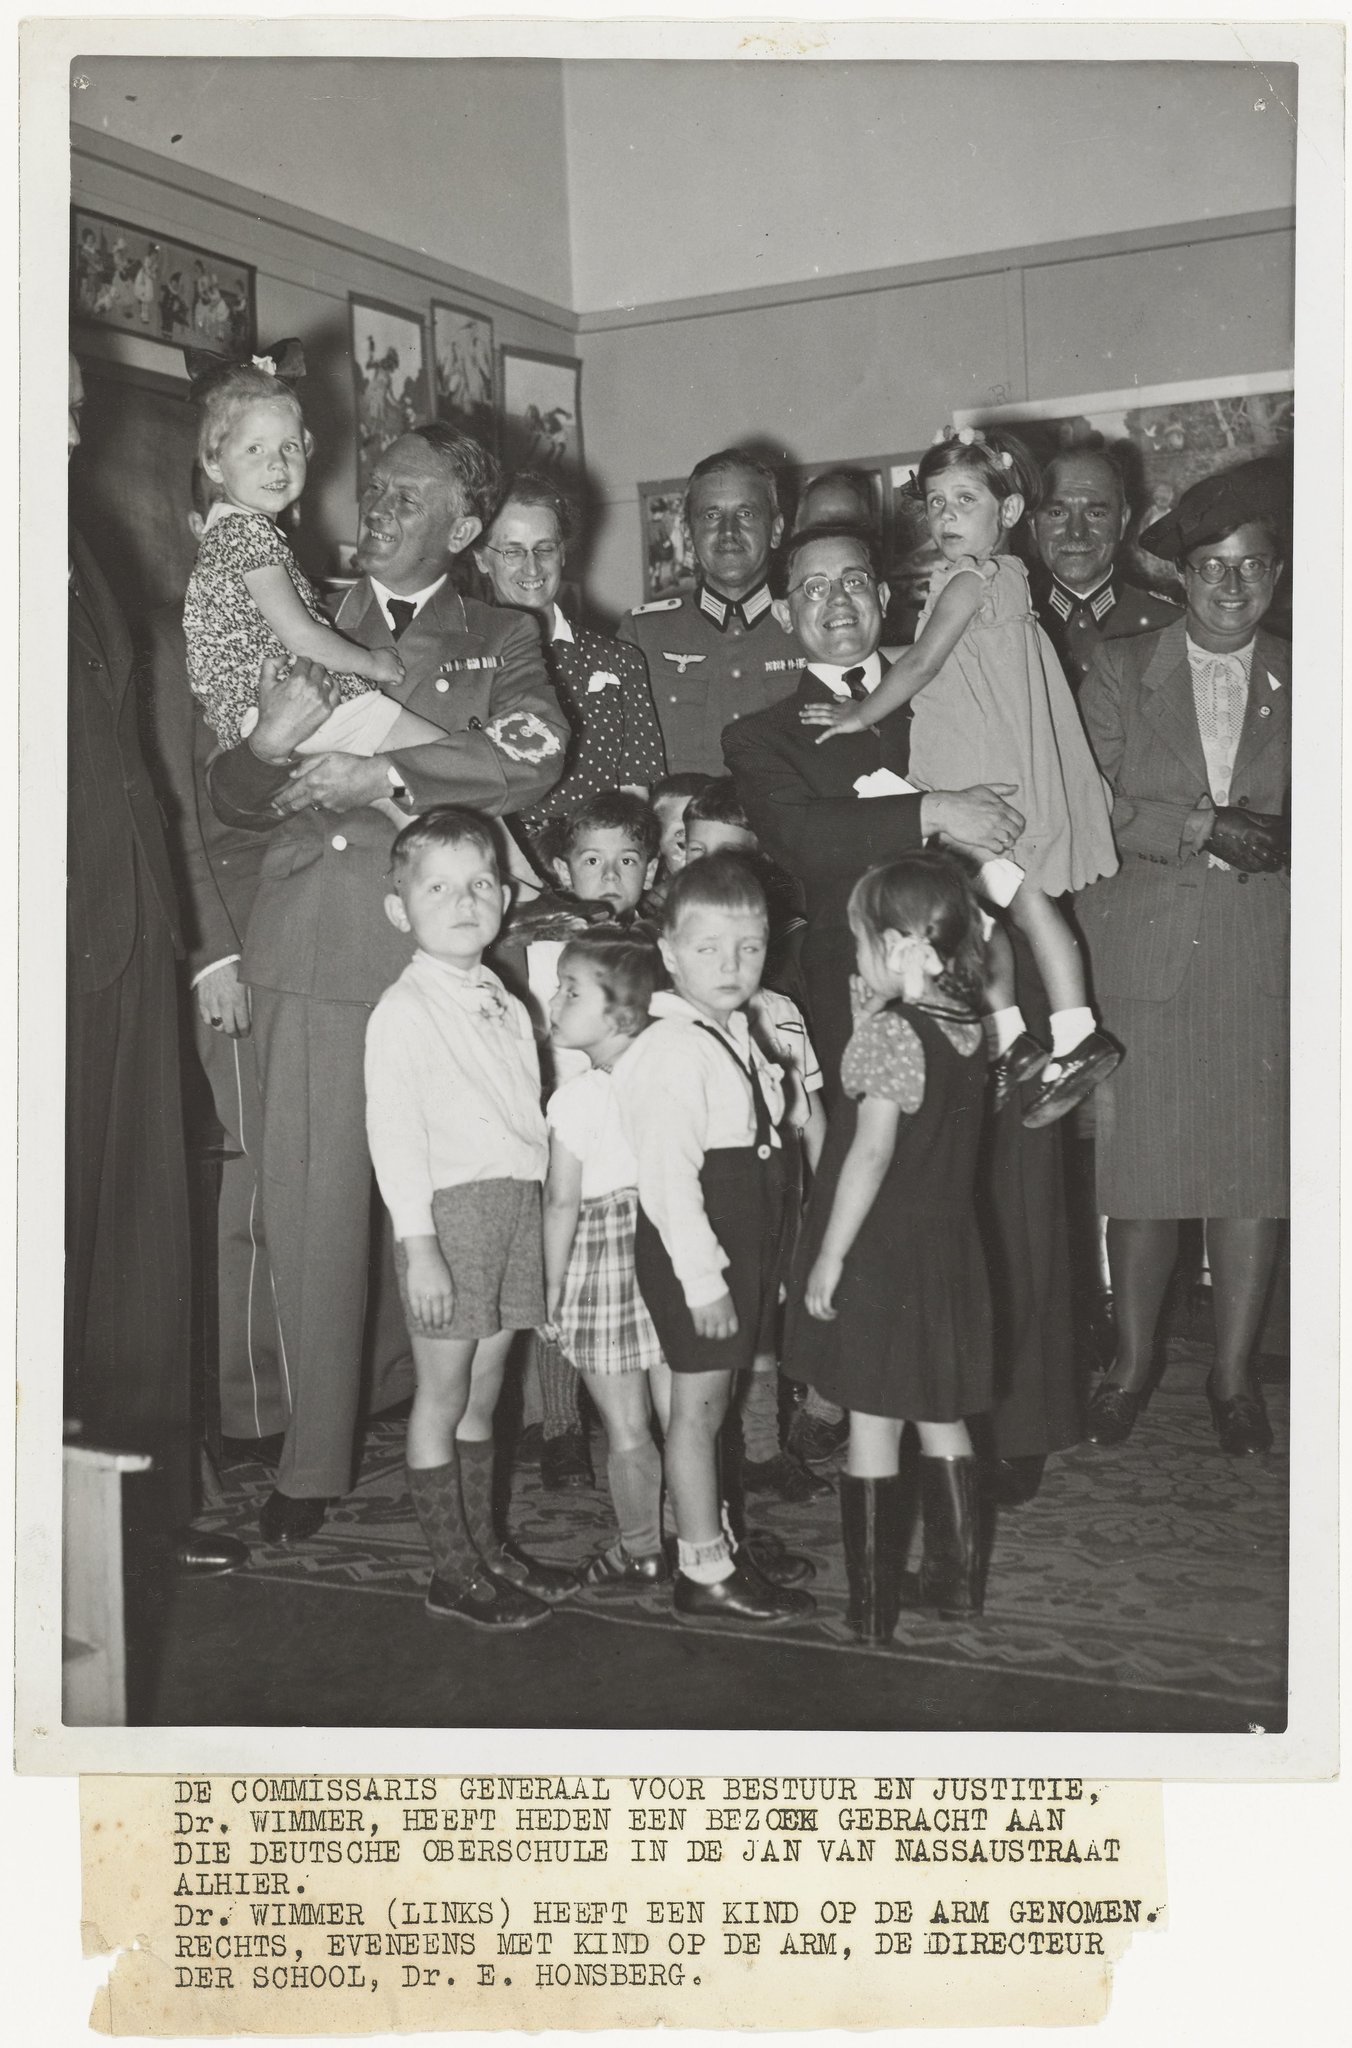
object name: photograph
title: Dr. Wimmer brengt een bezoek aan de Deutsche Oberschule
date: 1940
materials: photographic support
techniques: photography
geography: the hague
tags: austria, means of multiplying texts (other than printing), the hague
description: Dr. Friedrich Wimmer, links, Commissaris Generaal voor Bestuur en Justitie heeft een bezoek gebracht aan de Deutsche Oberschule met nog enige anderen hoge Duitsers. Hij was plaatsvervanger van Seyss Inquart. Tekststrookje aan foto geplakt.